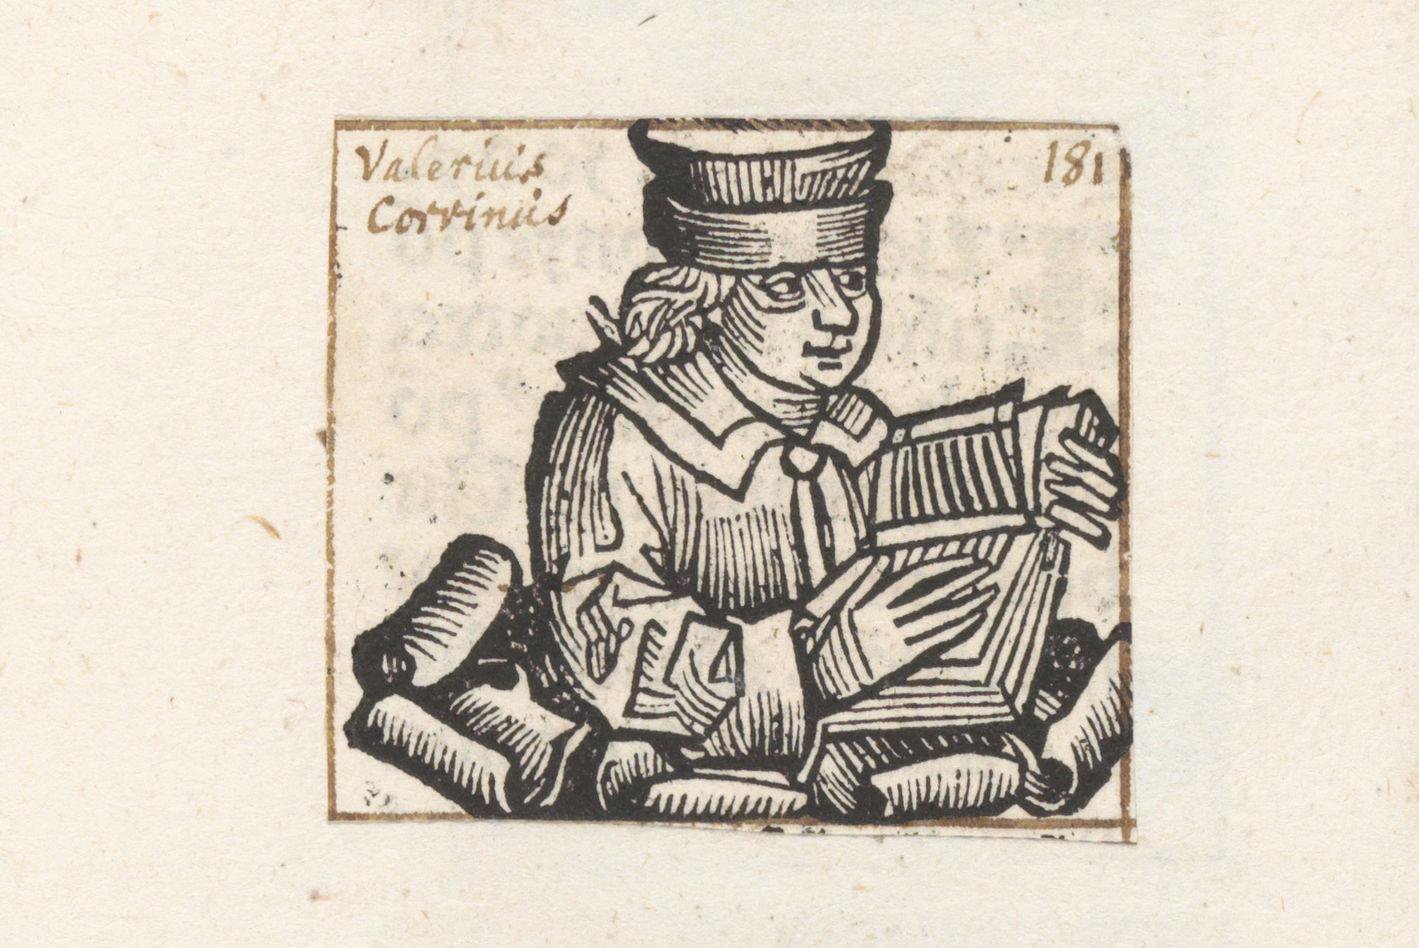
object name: print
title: [Valerius Corvinus]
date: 1493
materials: paper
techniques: letterpress printing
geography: nuremberg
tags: reading, male persons from classical history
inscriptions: inscription: ‘Valerius Corvinus / 181’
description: De houtsnede wordt gebruikt als boekillustratie in de Liber Chronicarum (of Neurenbergkroniek) van Hartmann Schedel, verschenen in het Latijn en Duits in 1493. Zie de Latijnse uitgave, folio 79r.